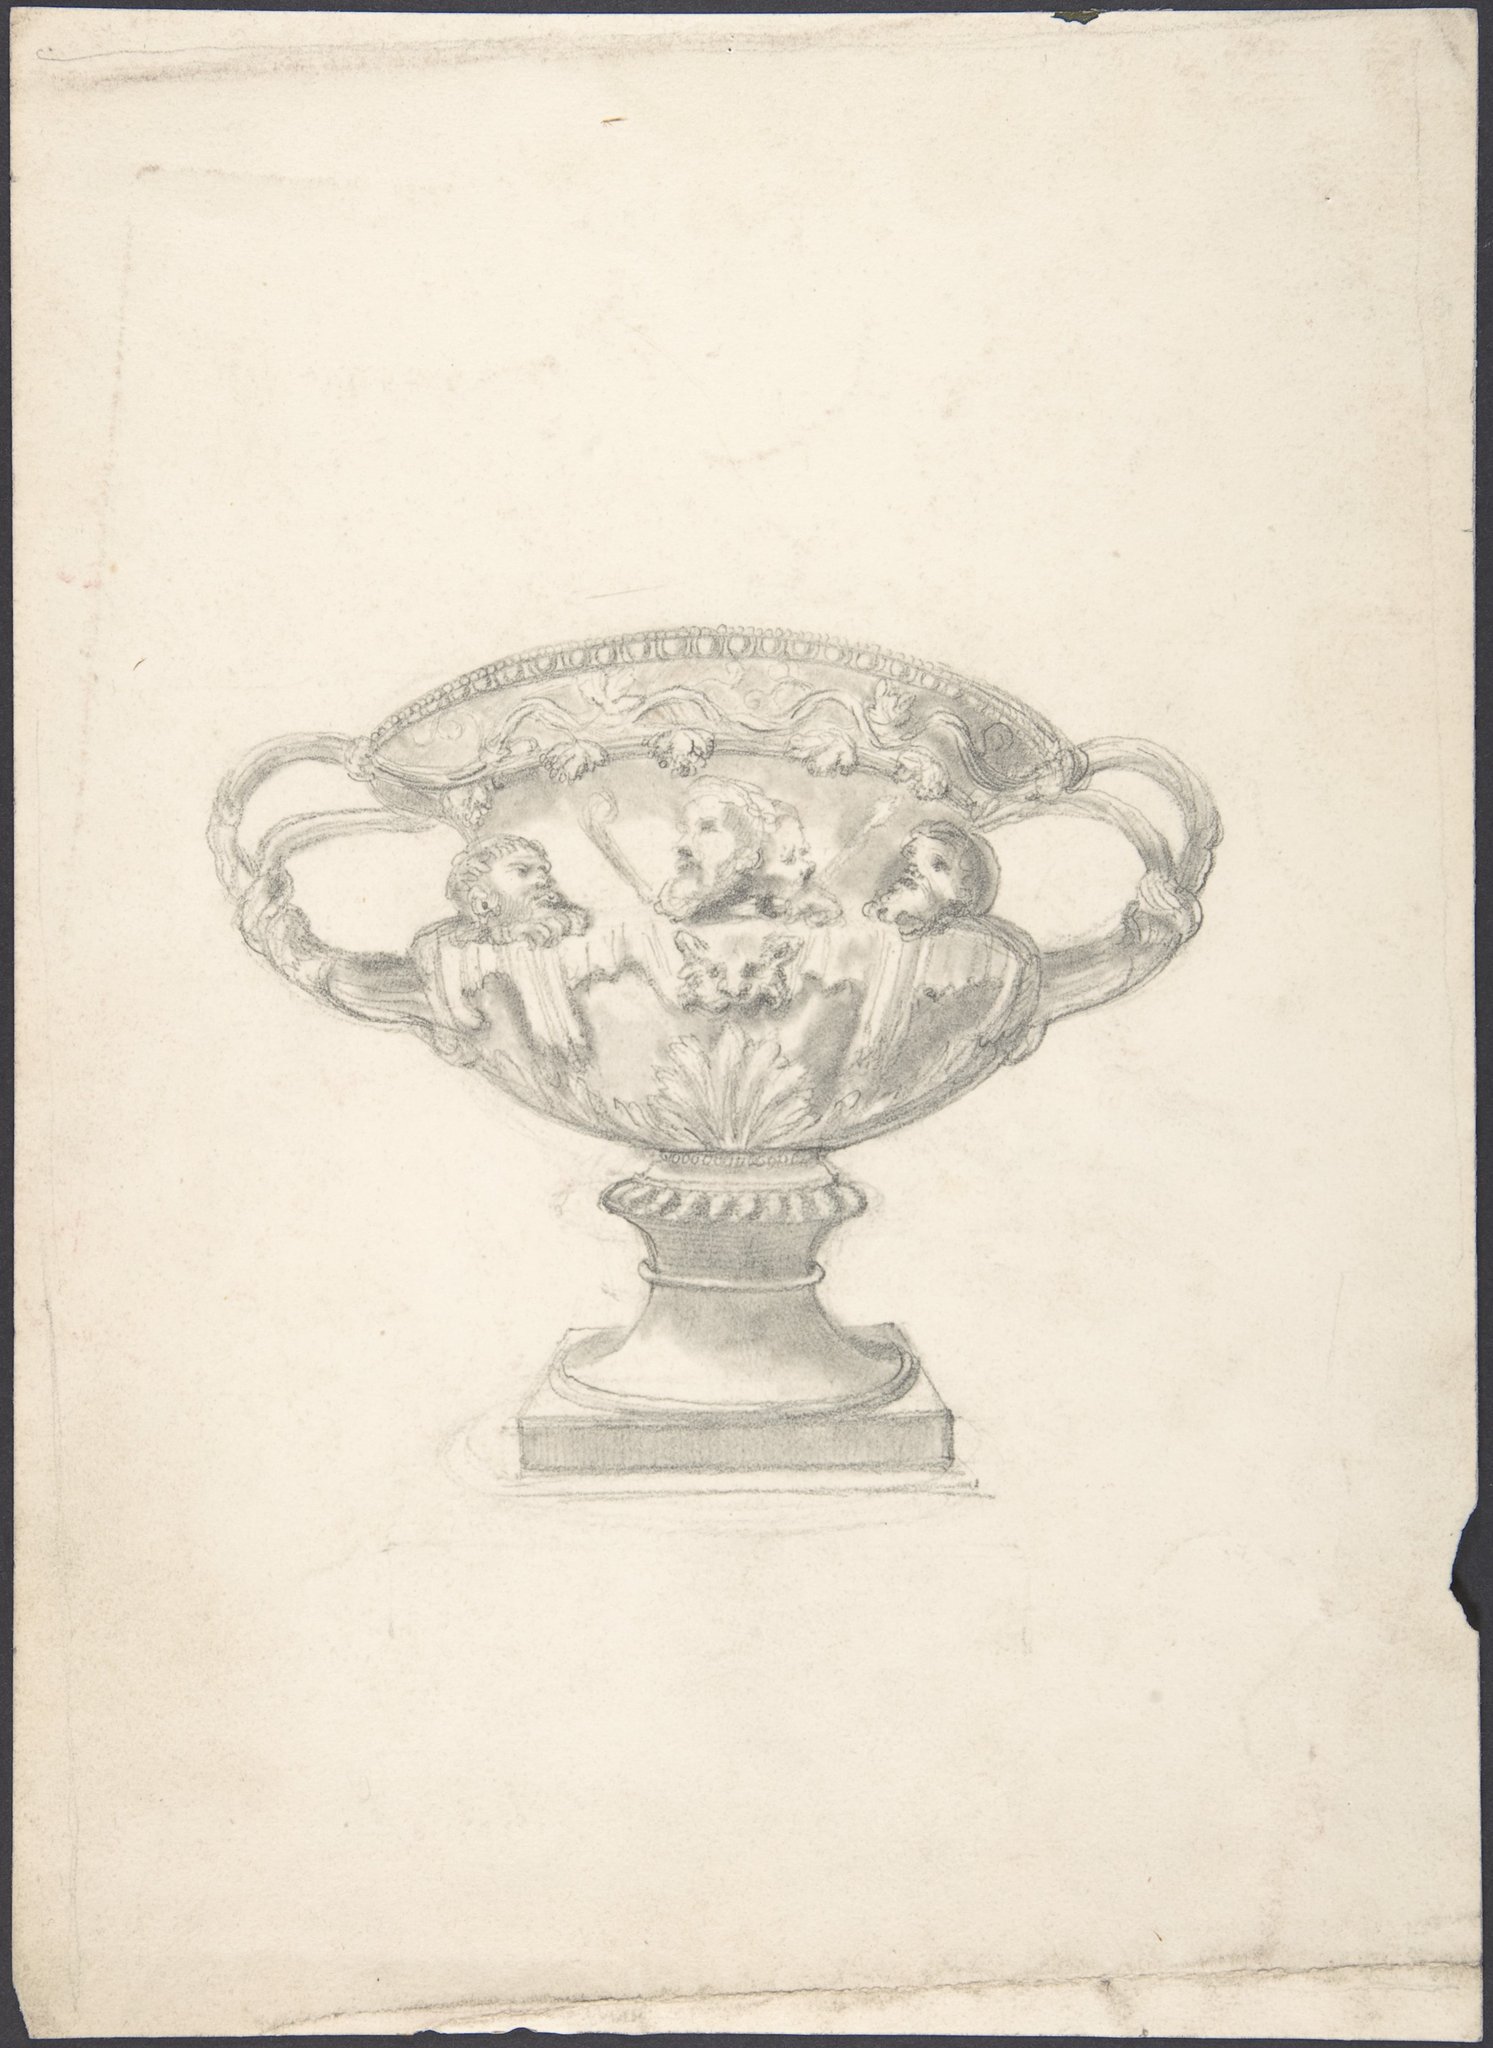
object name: drawing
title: Vase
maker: anonymous, british, 19th century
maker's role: artist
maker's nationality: british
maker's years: 1800-1900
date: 1801-1900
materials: ink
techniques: brush, pen, wash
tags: faces,men,vases